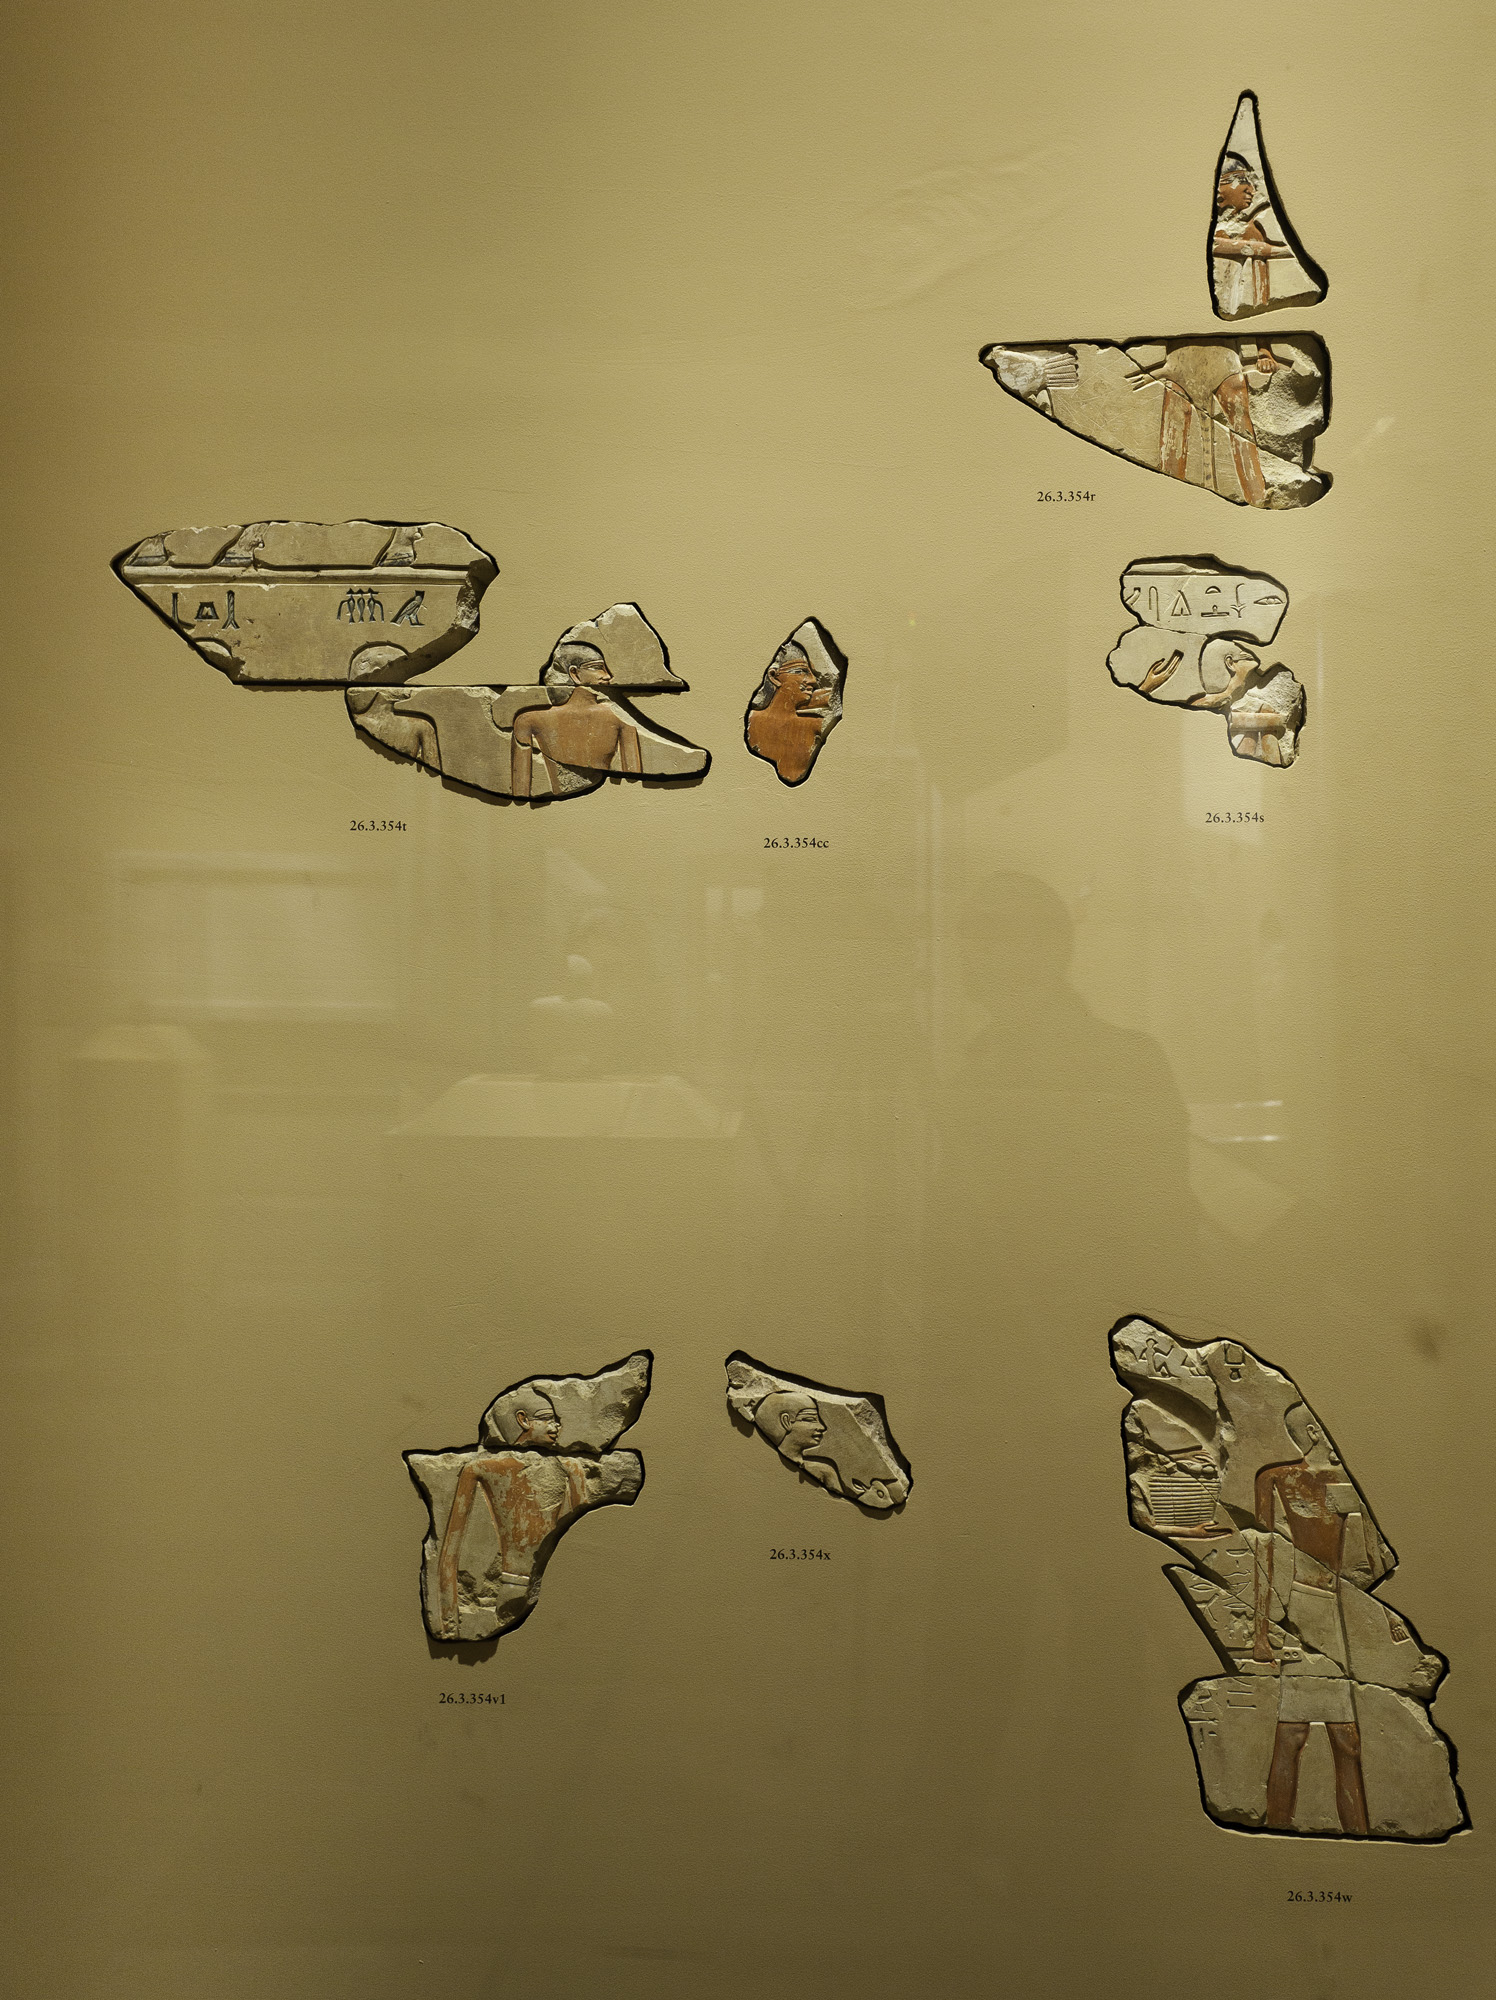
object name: relief, tomb of khety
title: Relief scene of priests and attendants performing rites and bringing offerings to Khety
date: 2051-2000 BCE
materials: limestone, paint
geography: egypt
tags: men